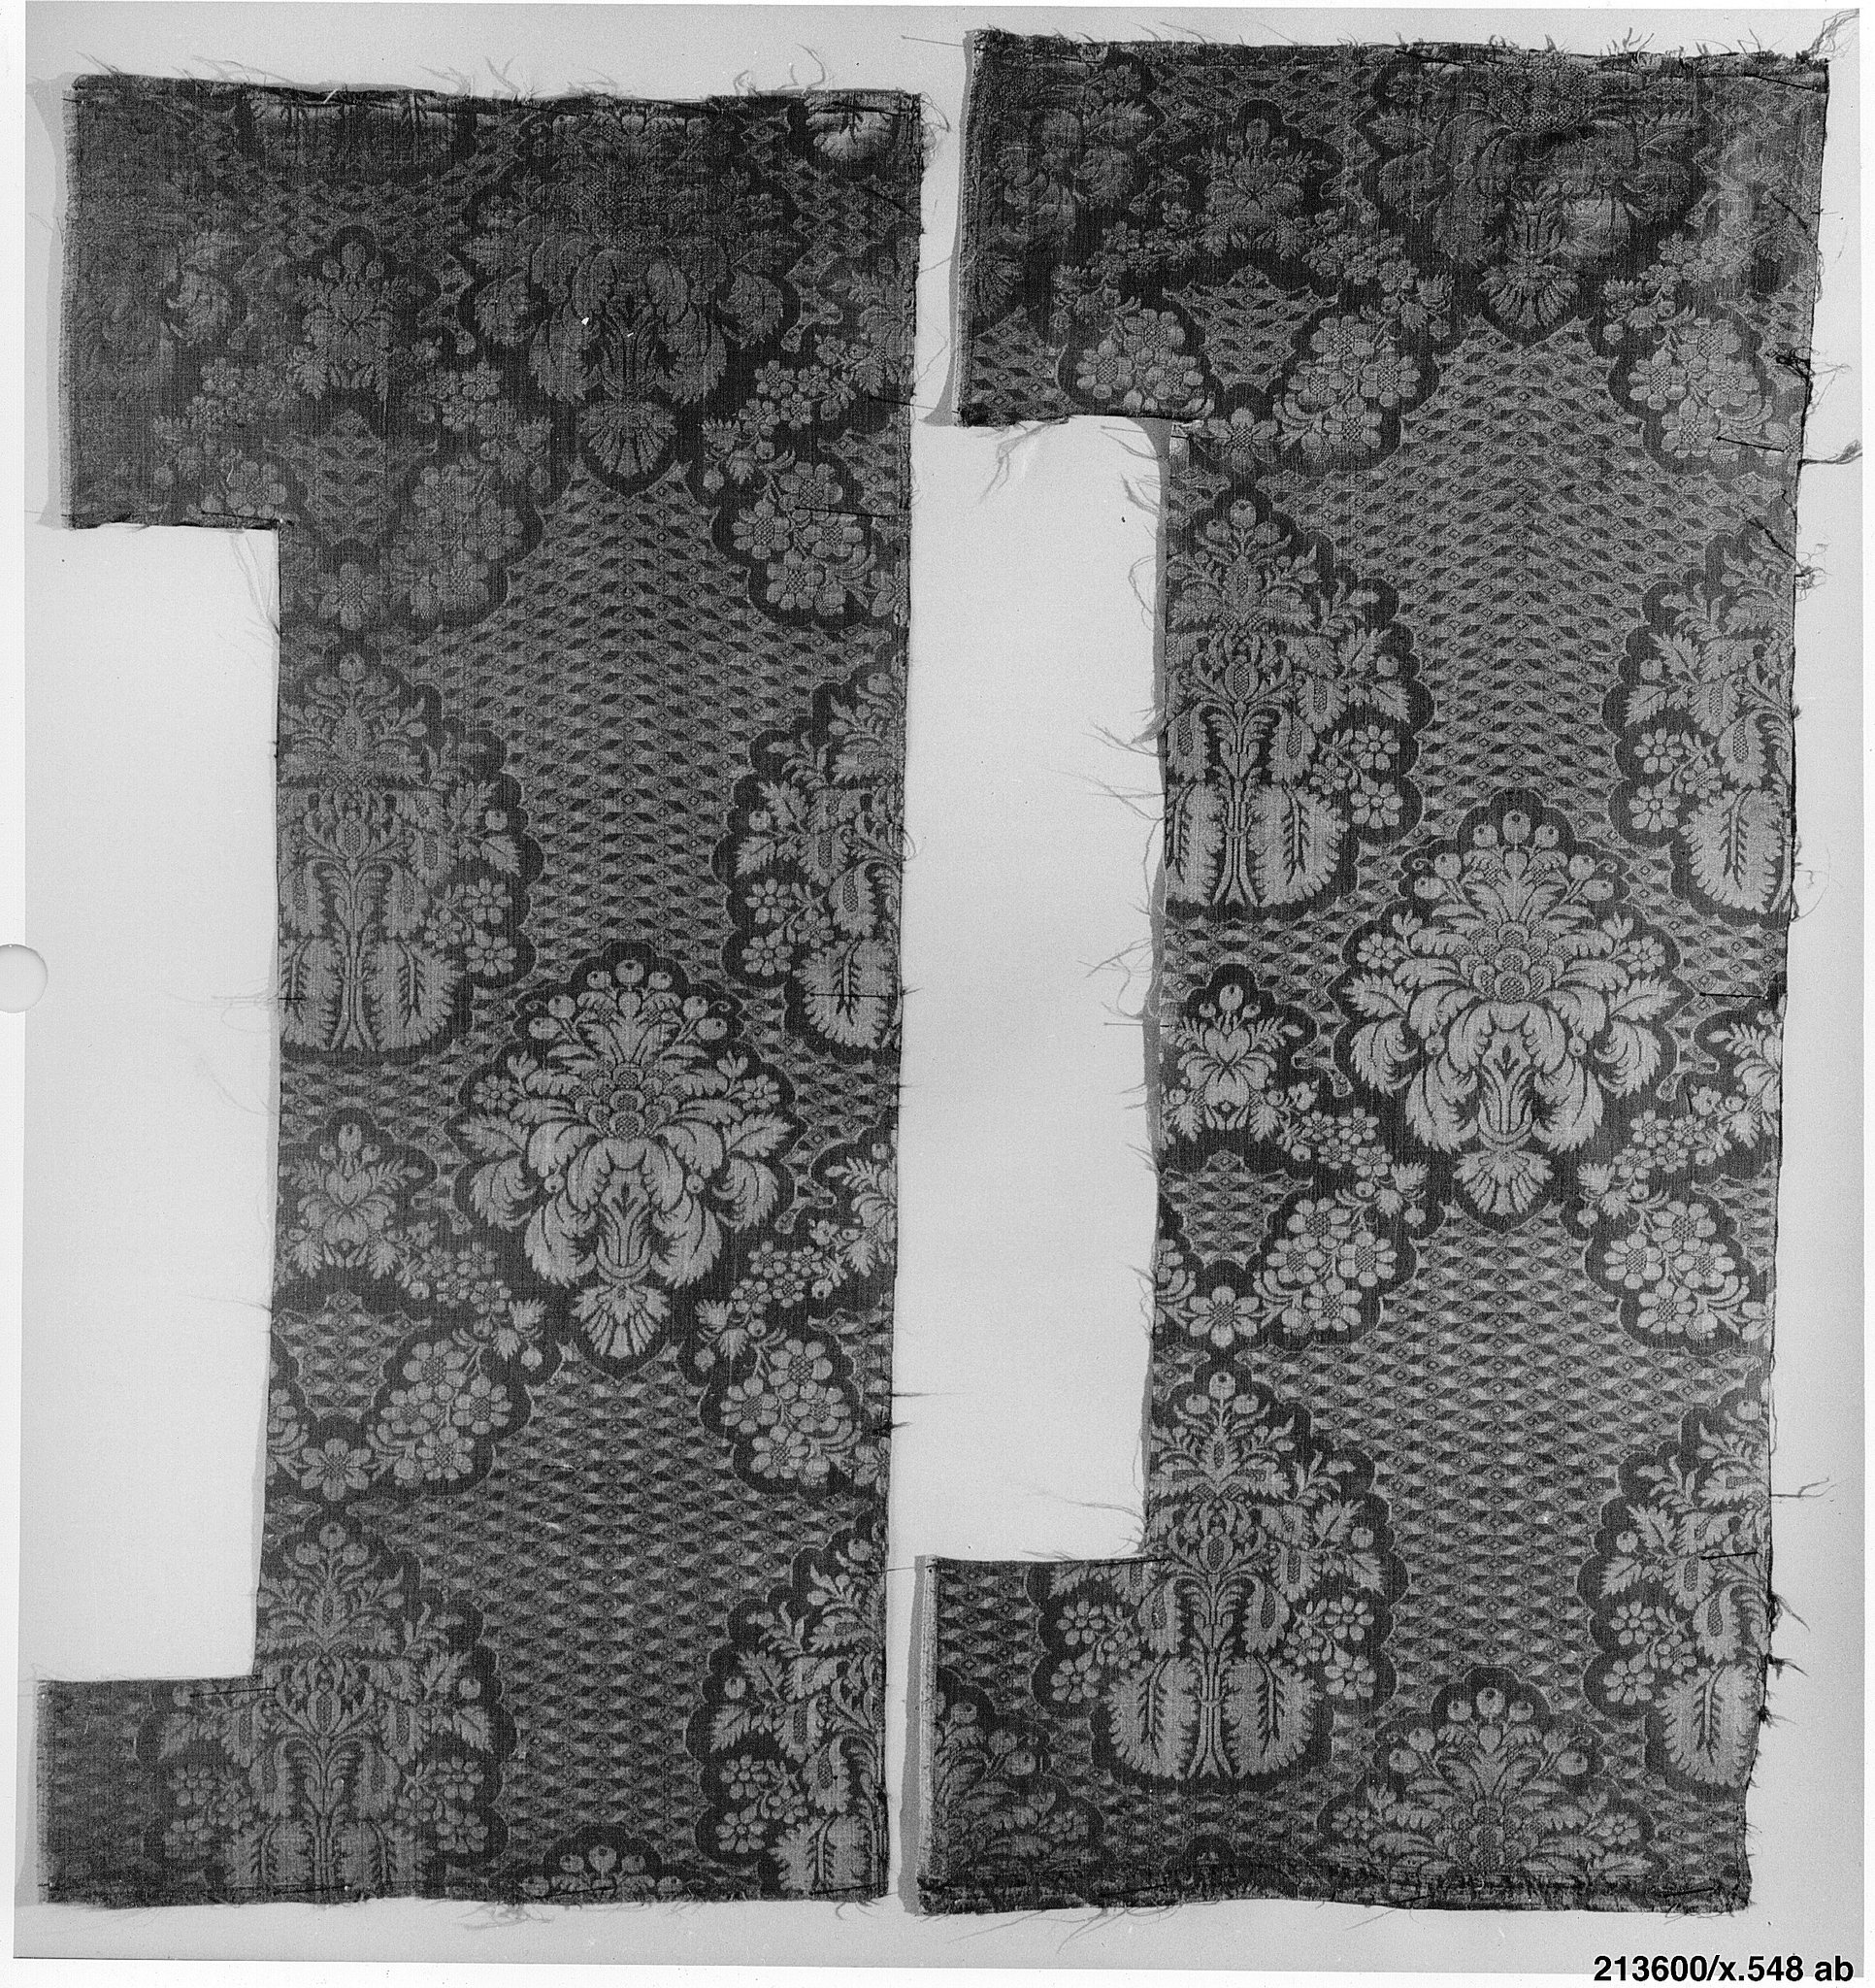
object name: piece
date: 1701-1800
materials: silk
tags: flowers,leaves